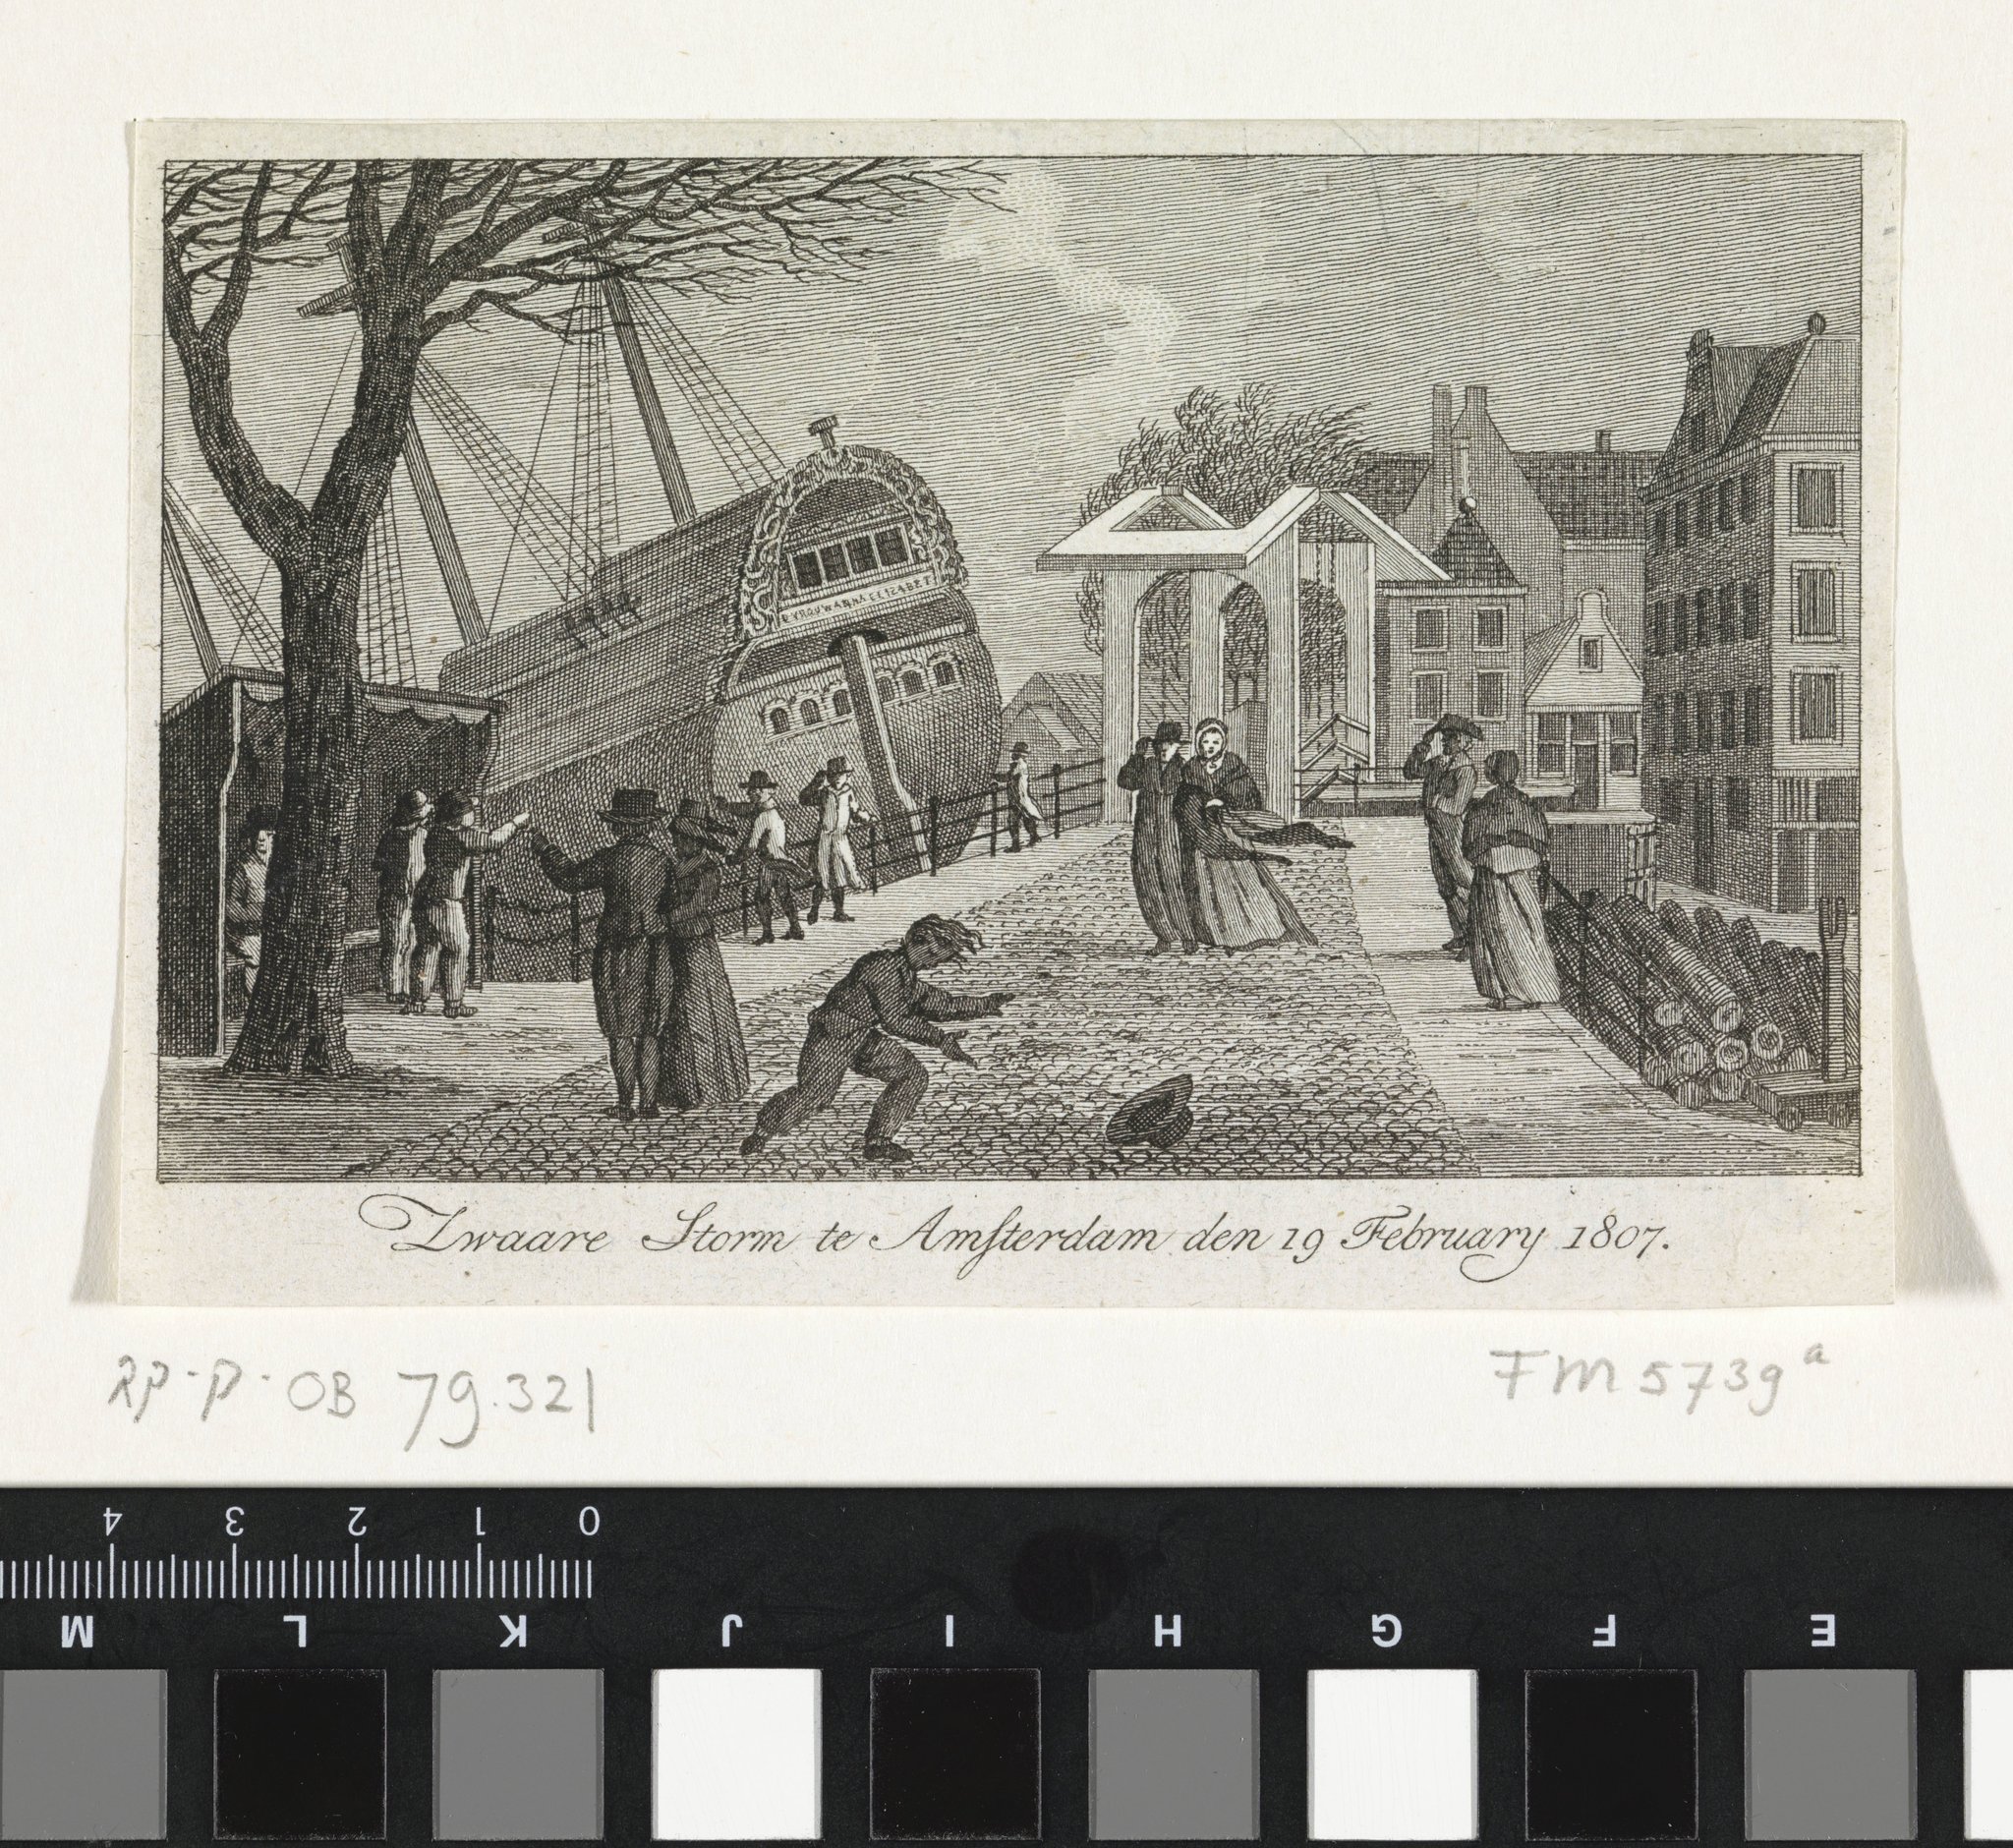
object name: print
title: Zware storm te Amsterdam, 1807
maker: Anonymous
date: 1807-1816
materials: paper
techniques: engraving, etching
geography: netherlands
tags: storm on land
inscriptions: collector's mark: Lugt 2228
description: Volgens de beschrijving in Muller stelt dit het Blauwhoofd voor, het Amsterdamse Stadsarchief identificeert dit echter als de Zandhoeksbrug over de Realengracht, gezien vanaf de Zandhoek naar het Bickerseiland. Zie de beschrijving van nr. 010097005080 in die collectie. Gebruikt als illustratie in: Arend Fokke Simonsz, Arend. De vaderlandsche historie in themata. A.B. Saakes, Amsterdam: 1816 (6e druk), p. 190.